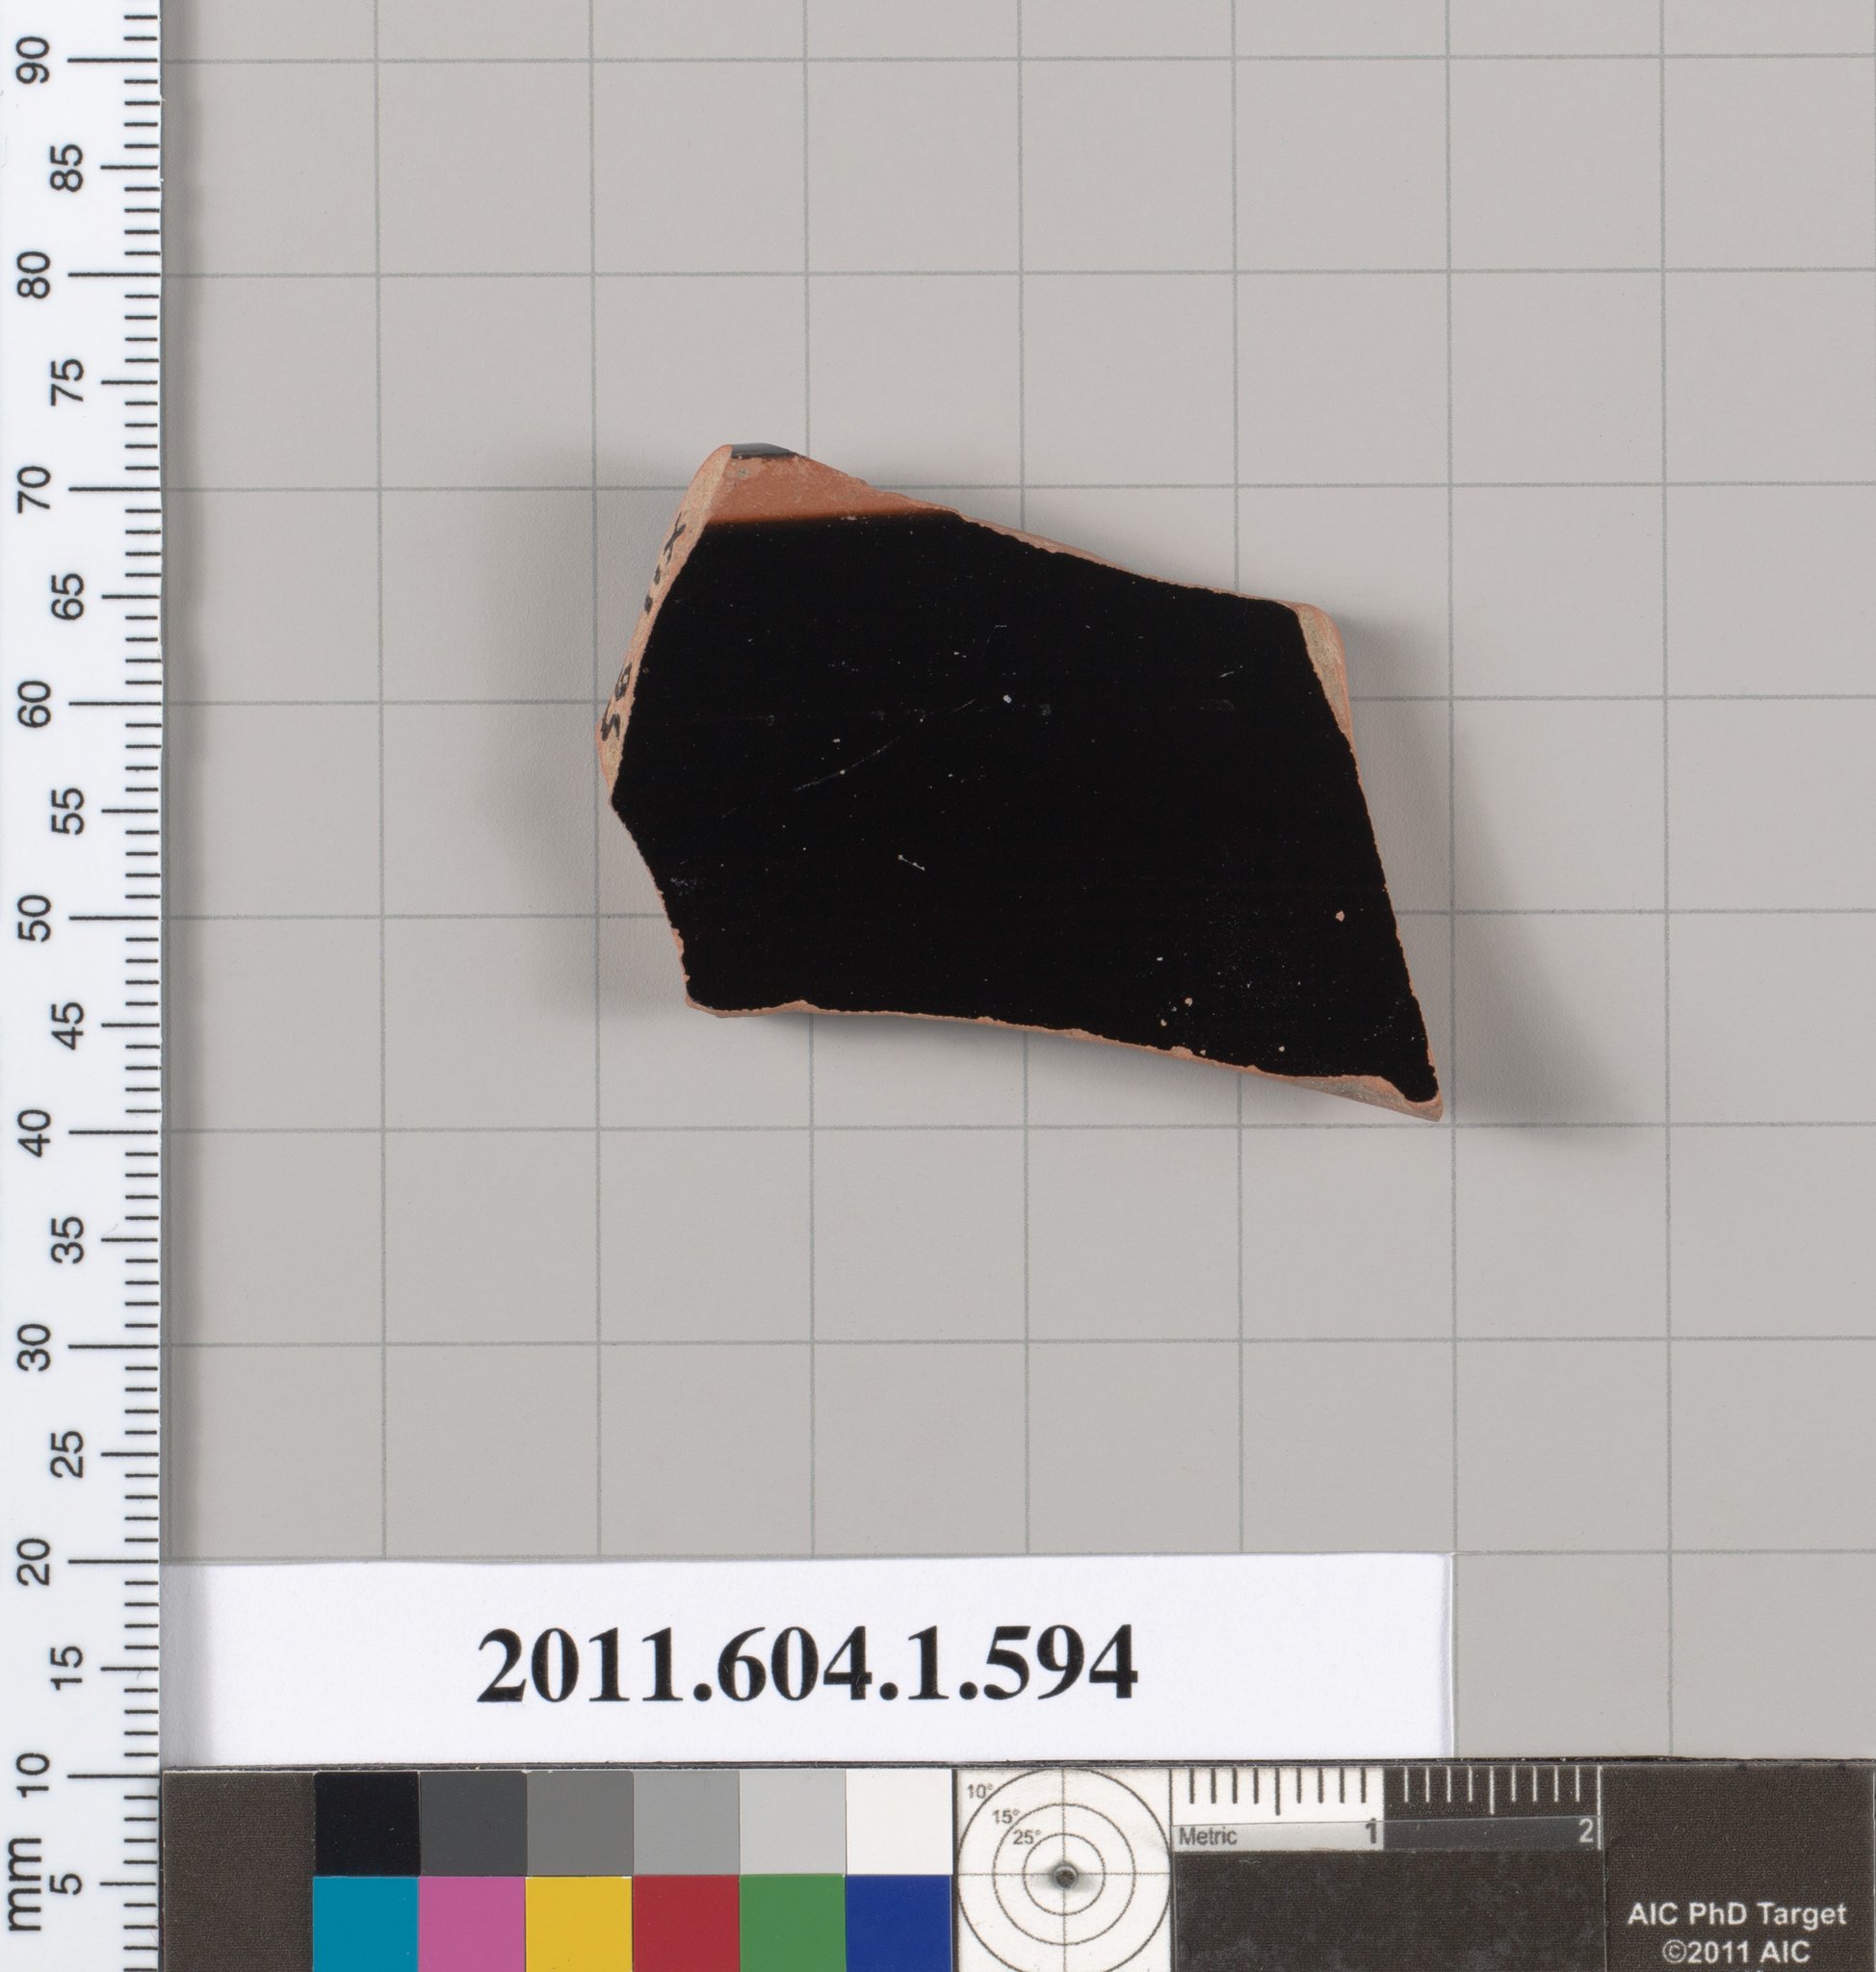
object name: kylix fragment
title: Terracotta fragment of a kylix (drinking cup)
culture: greek, attic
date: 475-451 BCE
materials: terracotta